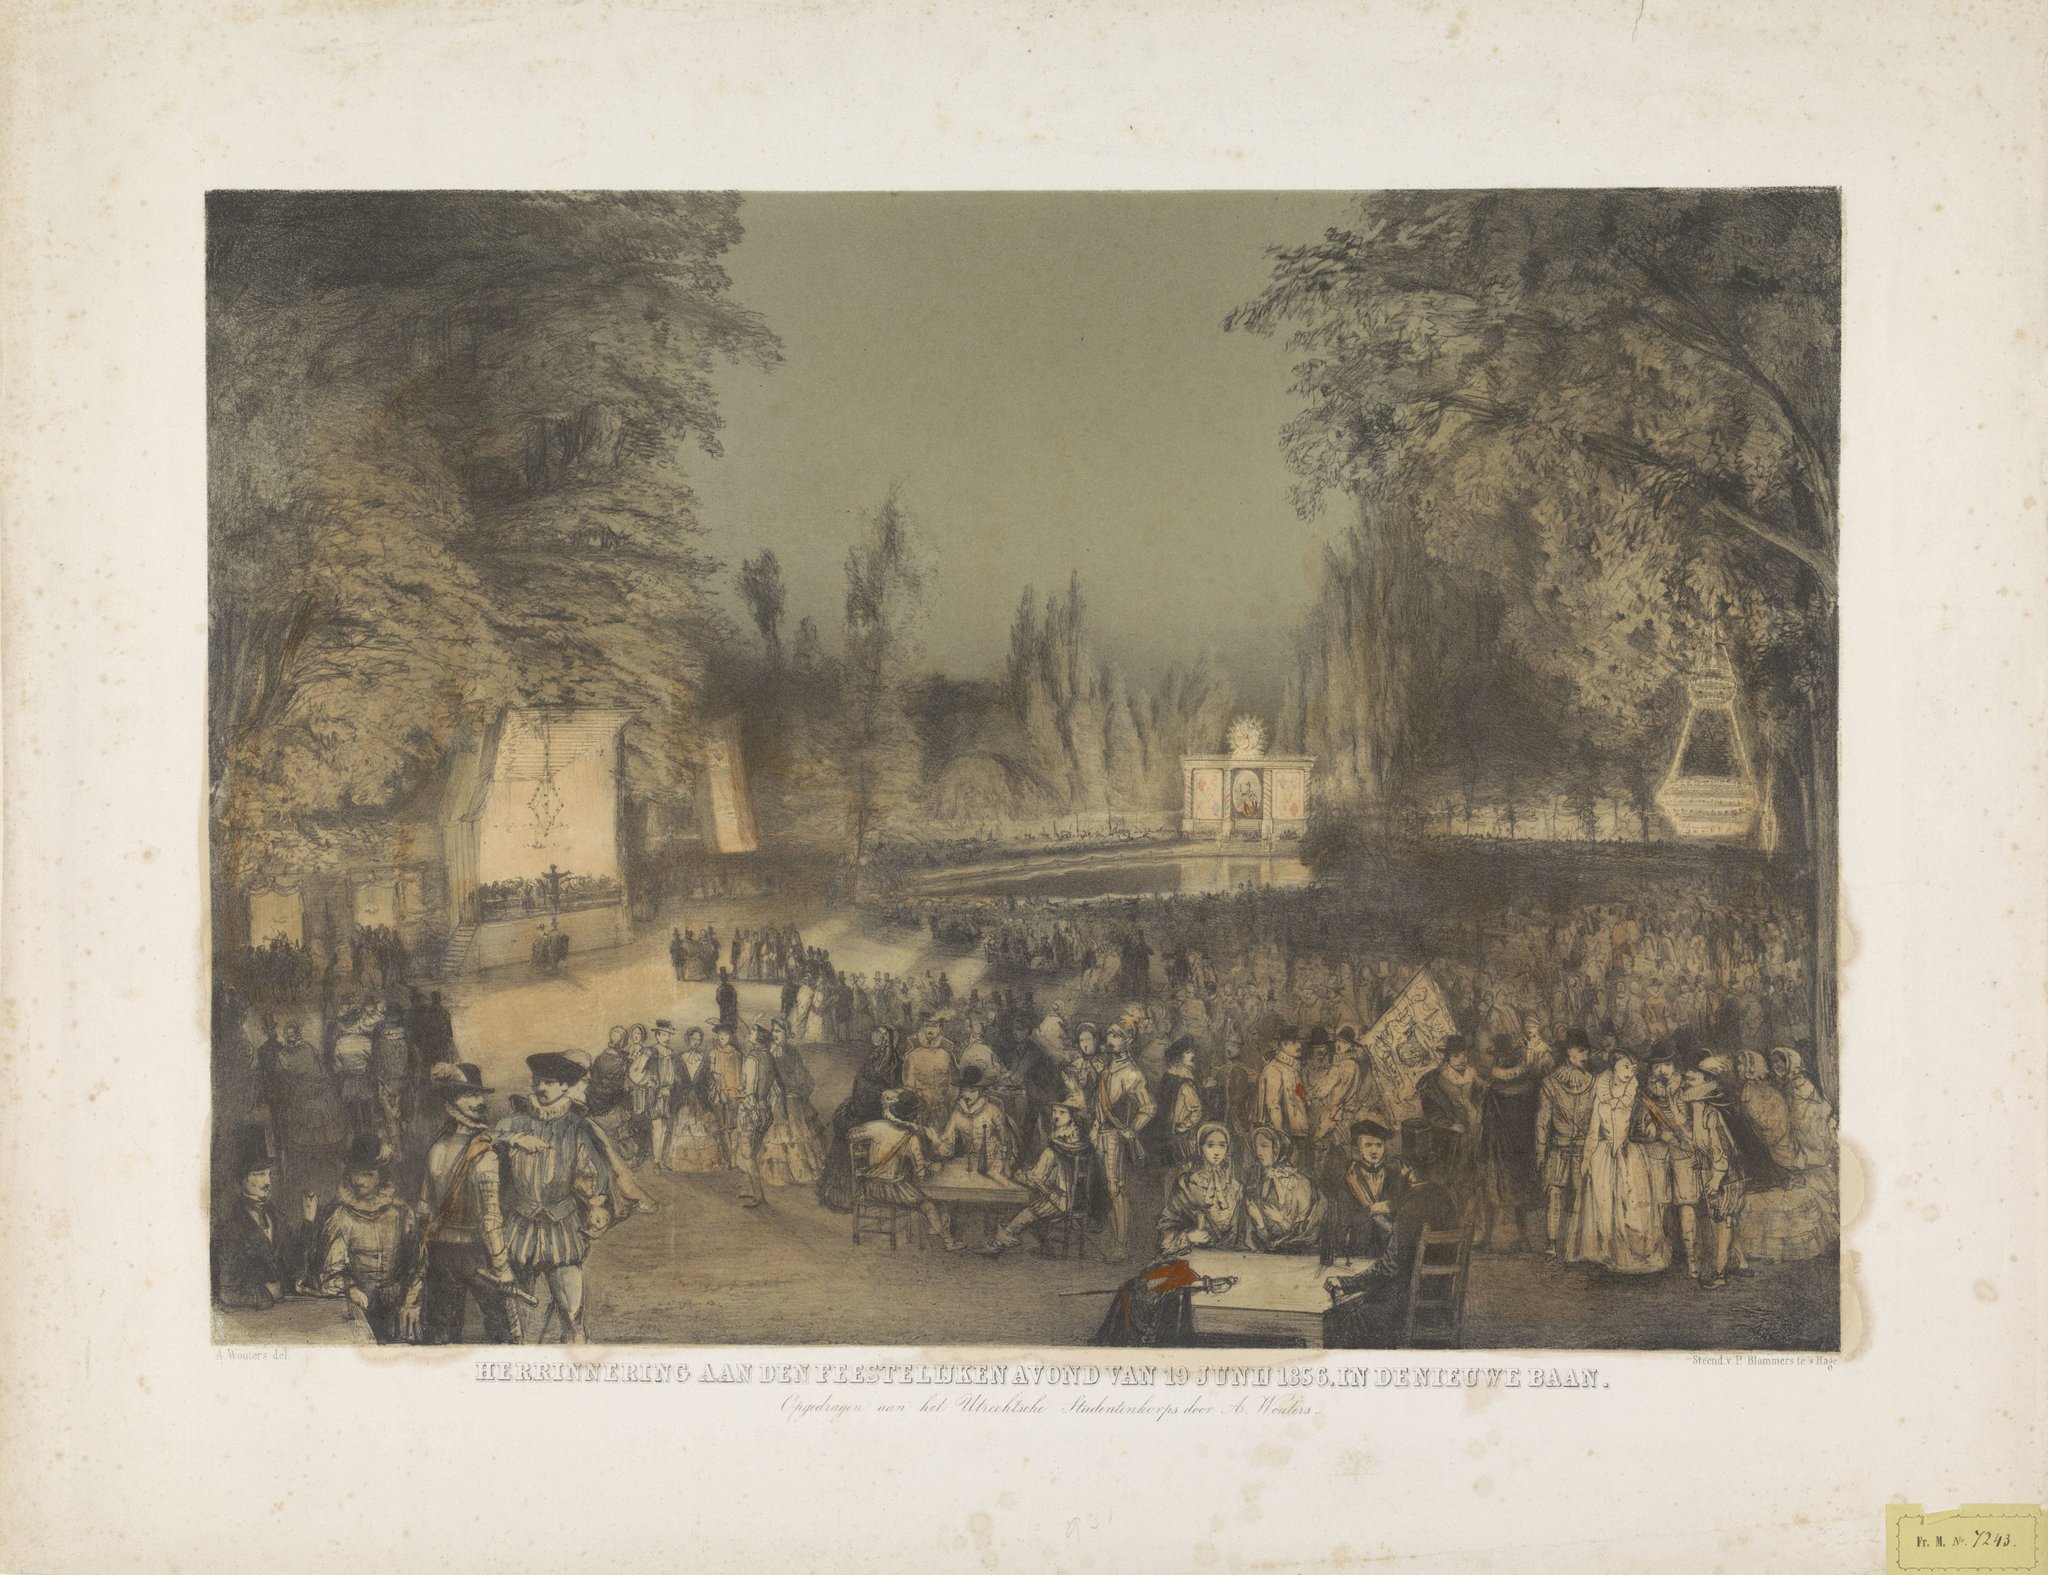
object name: print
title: Herinnering aan den feestelijken avond van 19 Junij 1856. In de Nieuwe Baan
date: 1856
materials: paper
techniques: lithograph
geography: utrecht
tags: students' pageant, party (students), costumes used in pageants, commemoration of the founding of a university, utrecht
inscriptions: collector's mark: Lugt 2228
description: Feestelijke bijeenkomst van de studenten van de Utrechtse Hogeschool op 19 juni 1856 bij de viering van het 220-jarig bestaan van de Hogeschool. De studenten in kostuums uit de tijd van prins Willem van Oranje bijeen in de Nieuwe Baan aan het eind van de Maliebaan te Utrecht, bij avond. Links wordt een concert gegeven.